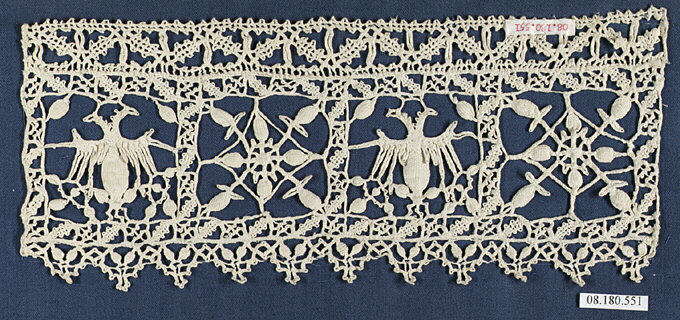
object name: piece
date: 1701-1800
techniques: lace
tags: birds